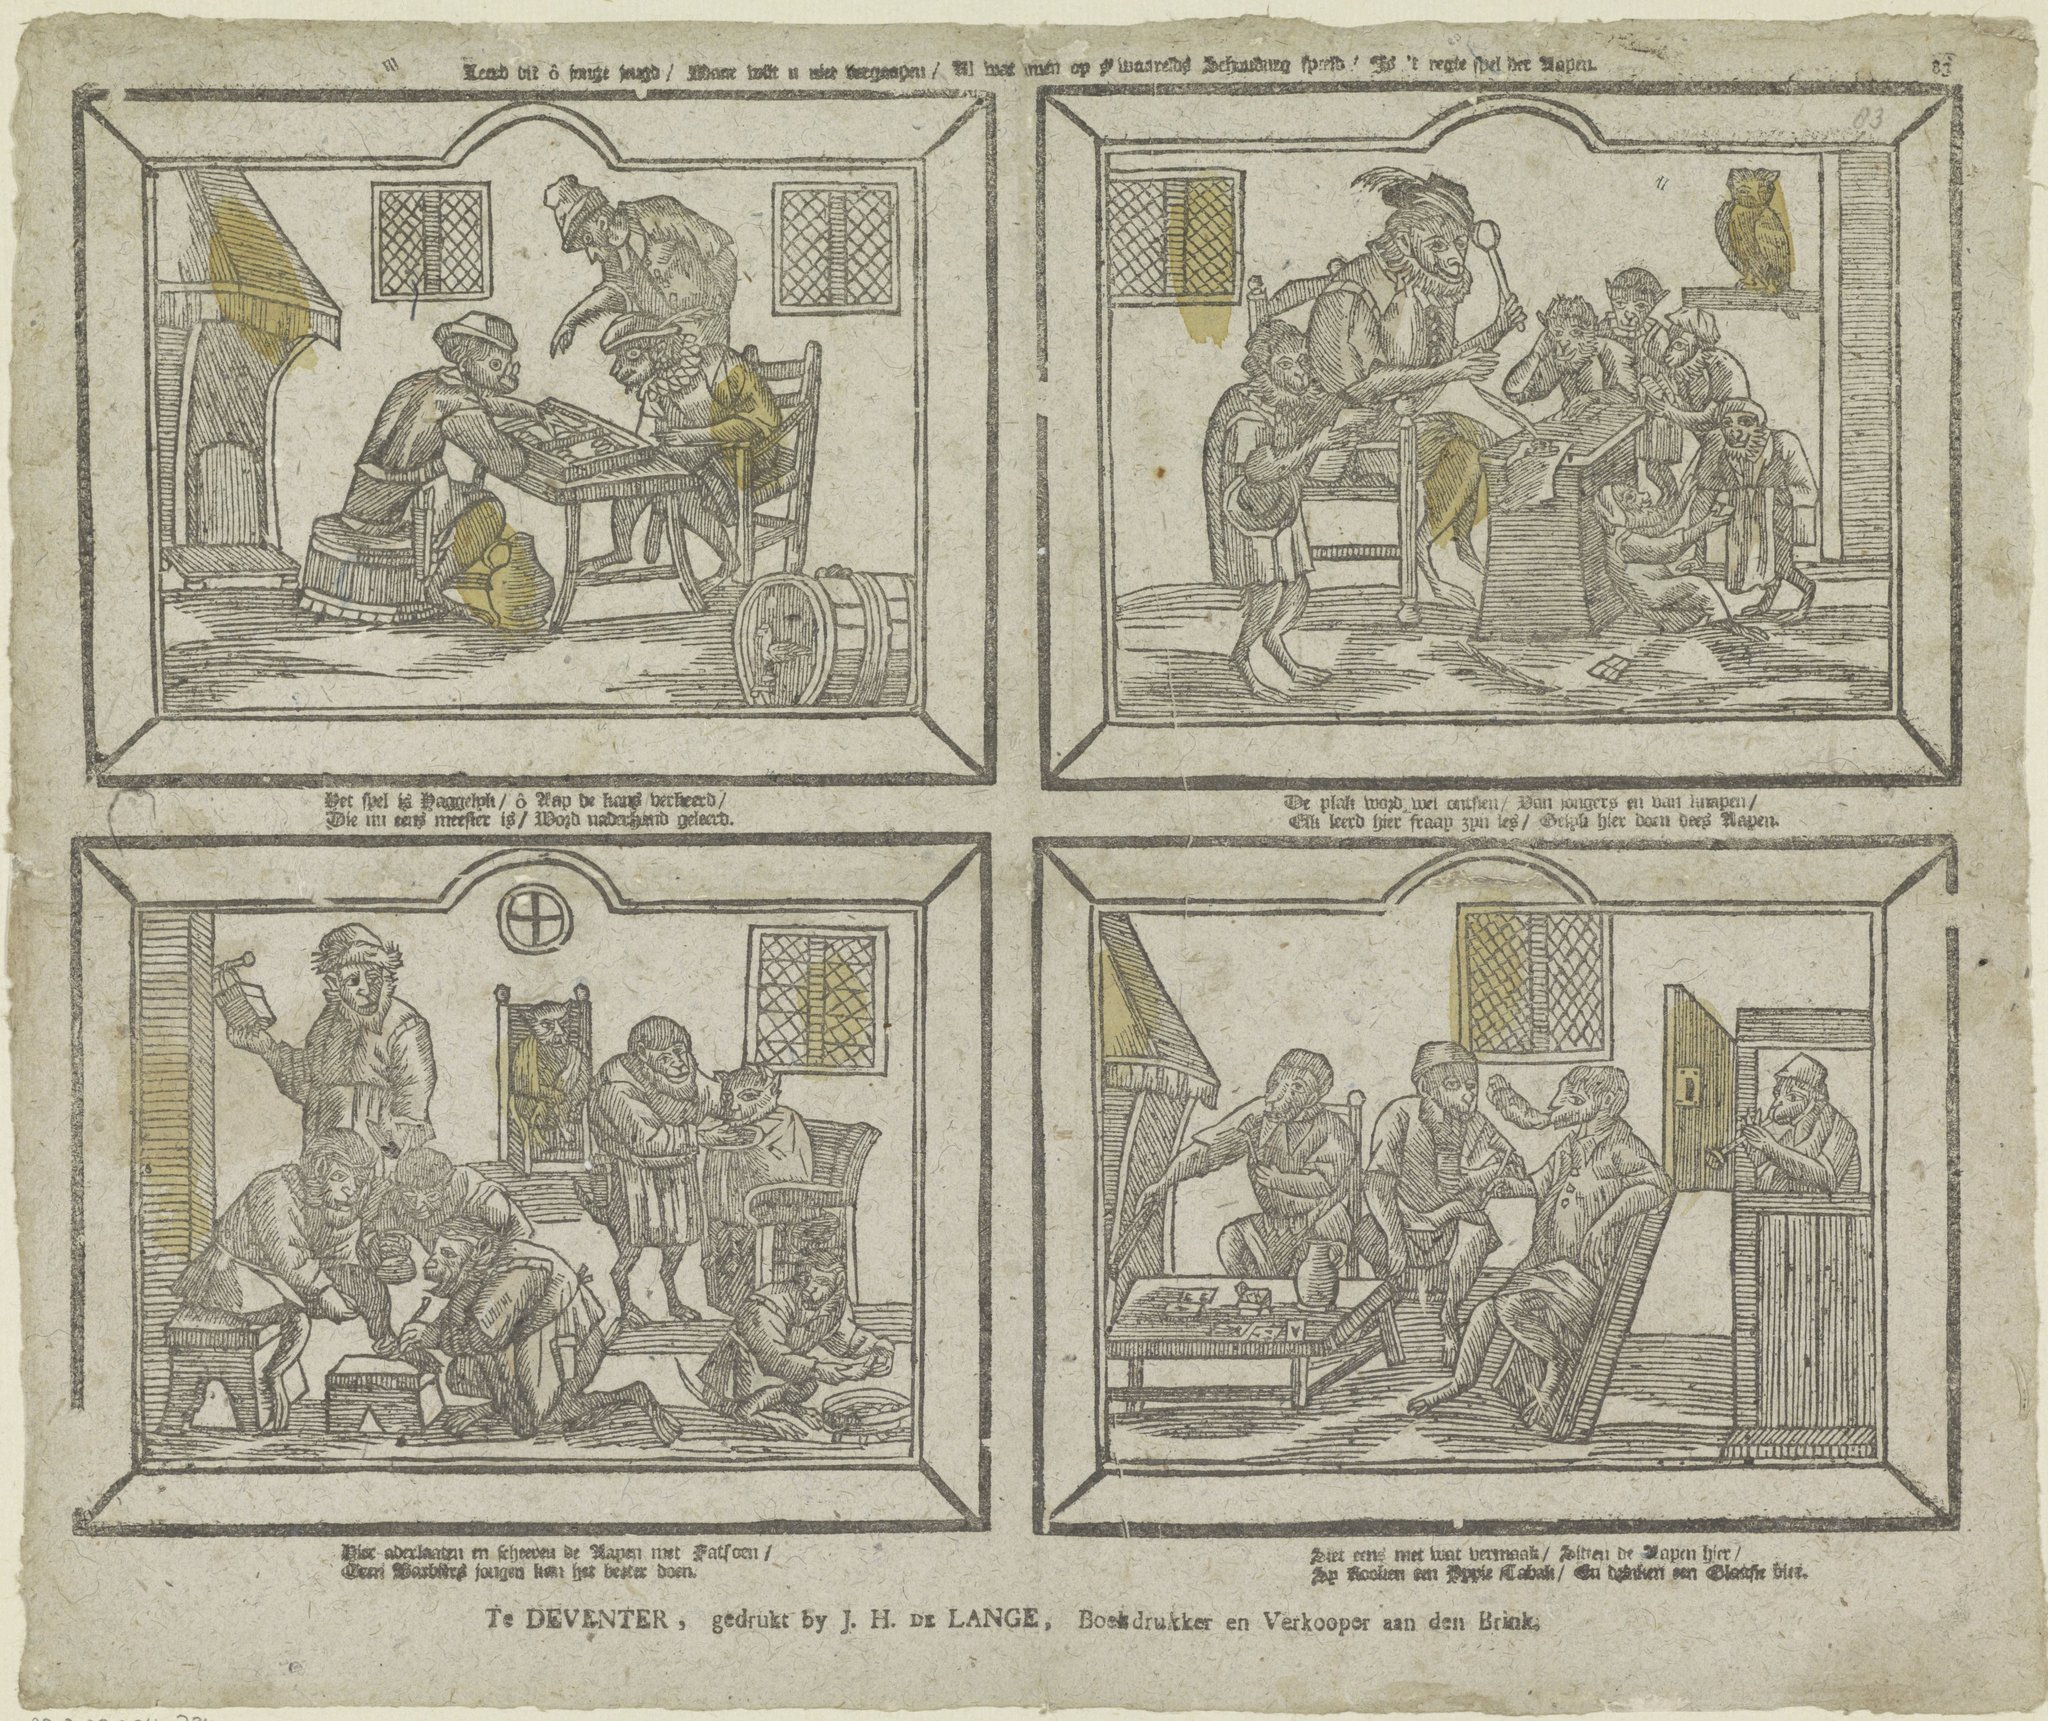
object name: print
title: Leerd dit o jonge jeugd / Maar wilt u niet vergaapen / Al wat men op 's waerelds schouwburg spreid / Is 't regte spel der aapen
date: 1787-1822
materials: paper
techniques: colour, letterpress printing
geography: netherlands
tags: monkeys, apes, 'mundus inversus', the reversed world, the topsy-turvy world, 'le monde bestourné'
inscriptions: collector's mark: Lugt 2760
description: Blad met 4 taferelen met apen die zich gedragen als mensen. Onder elke afbeelding een vers. Genummerd rechtsboven: 83.